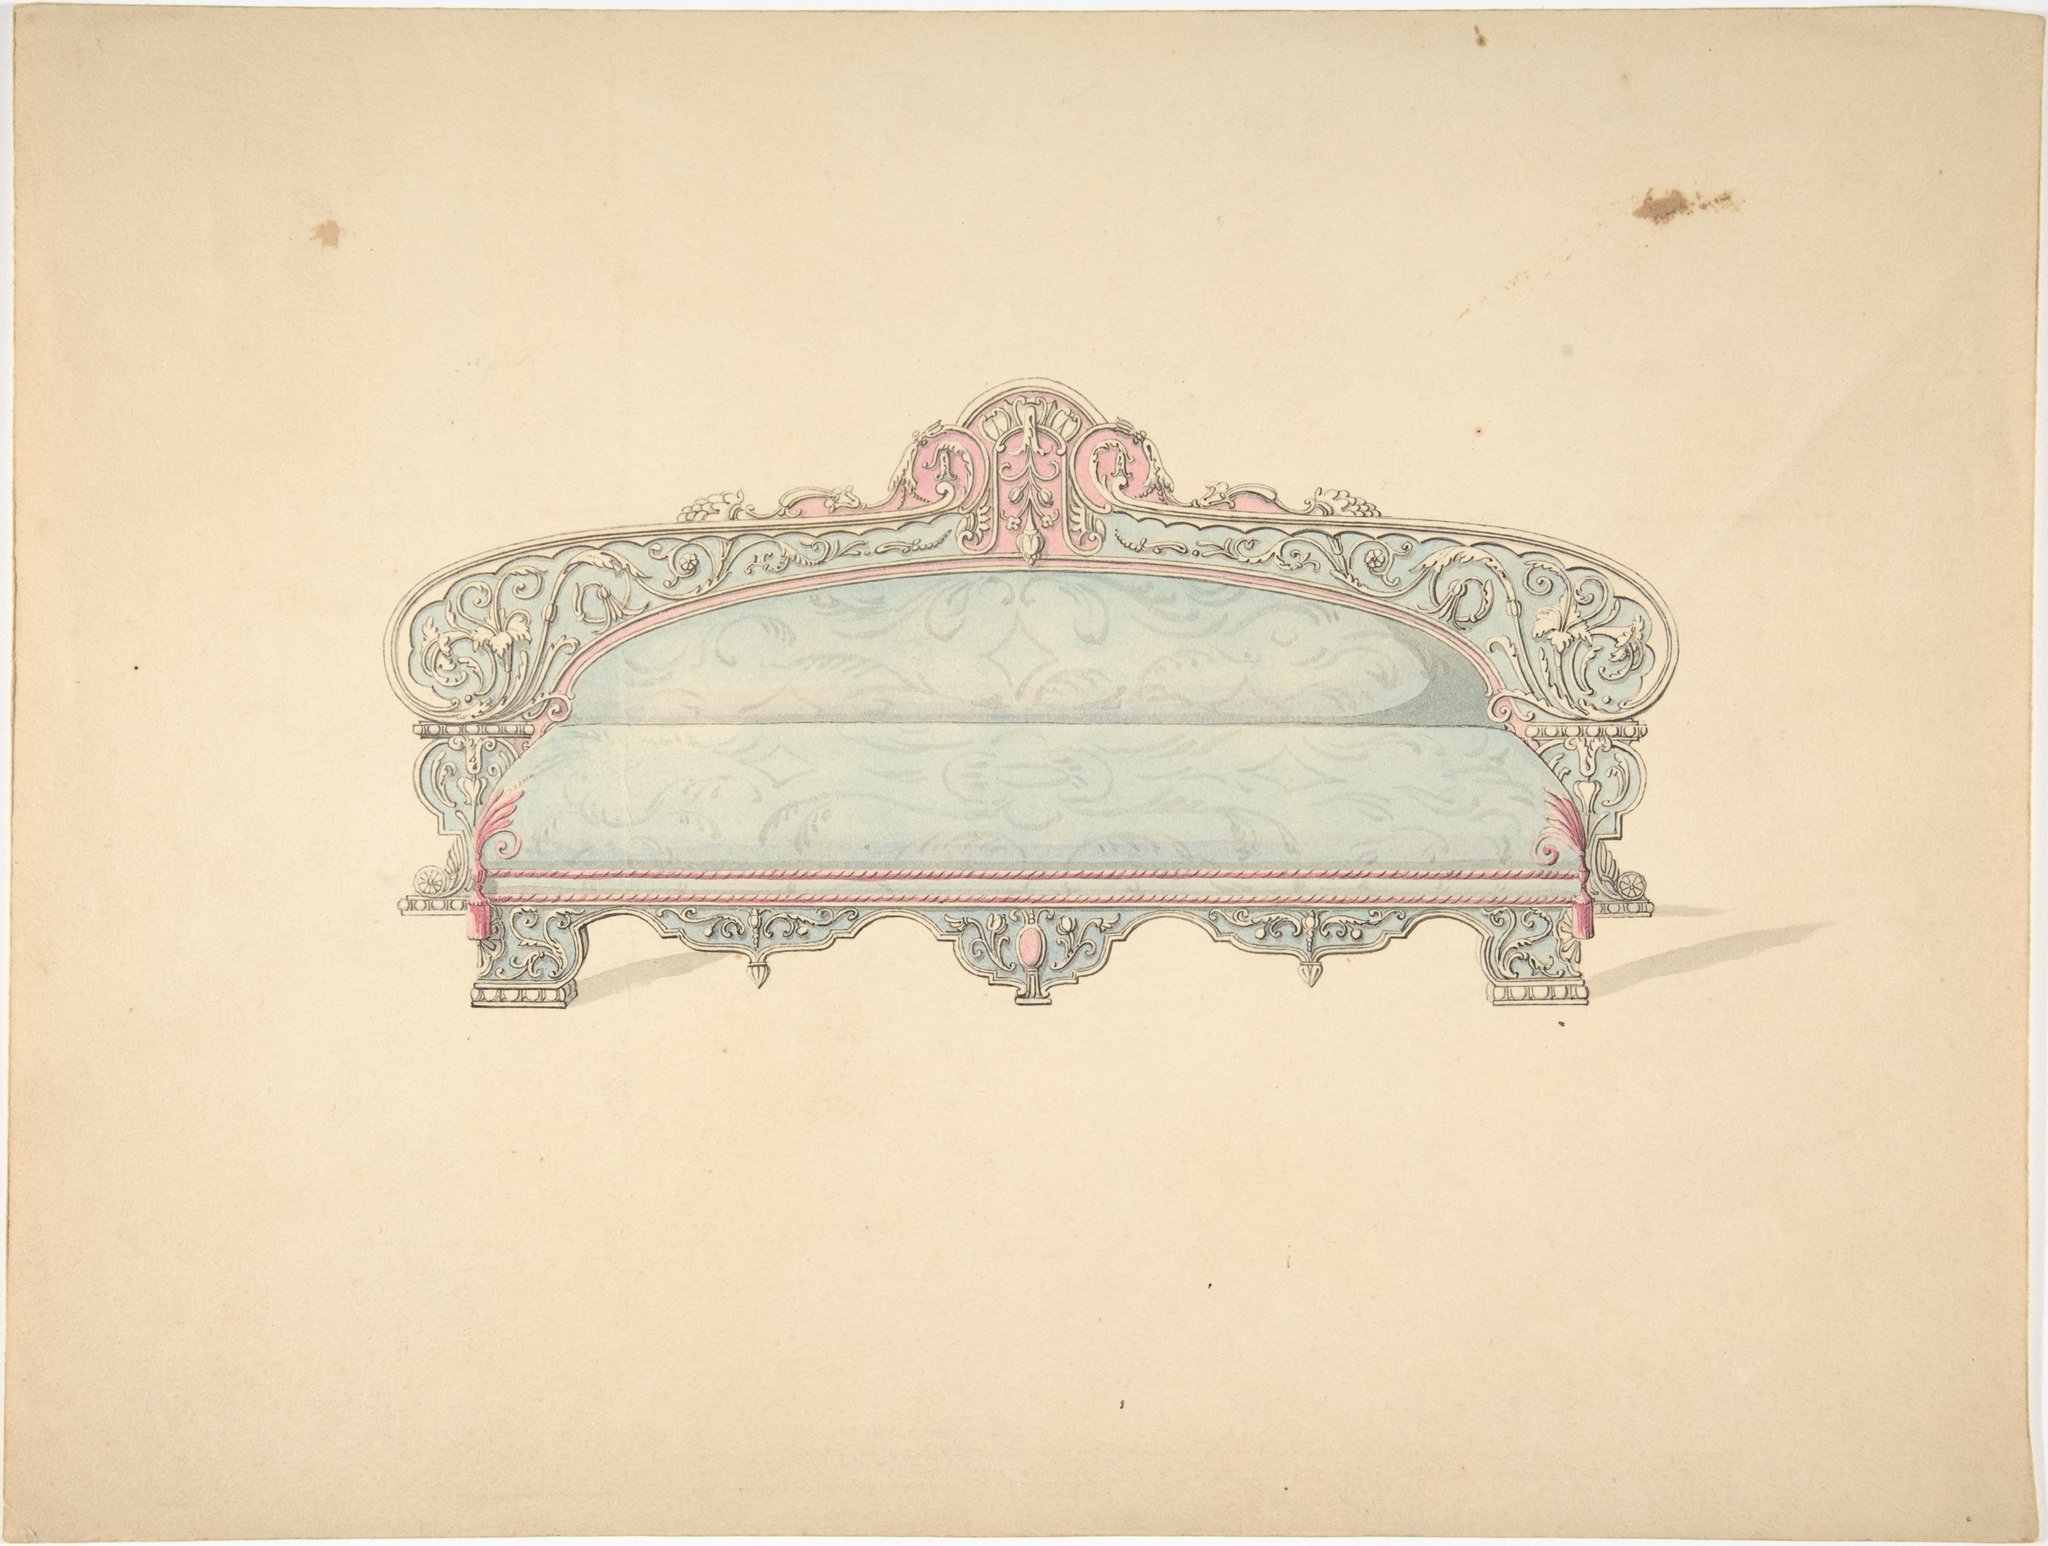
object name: drawing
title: Design for Ottoman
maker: robert william hume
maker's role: artist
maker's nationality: british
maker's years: 1816-1904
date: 1835-1900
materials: graphite, ink, watercolor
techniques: pen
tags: couches